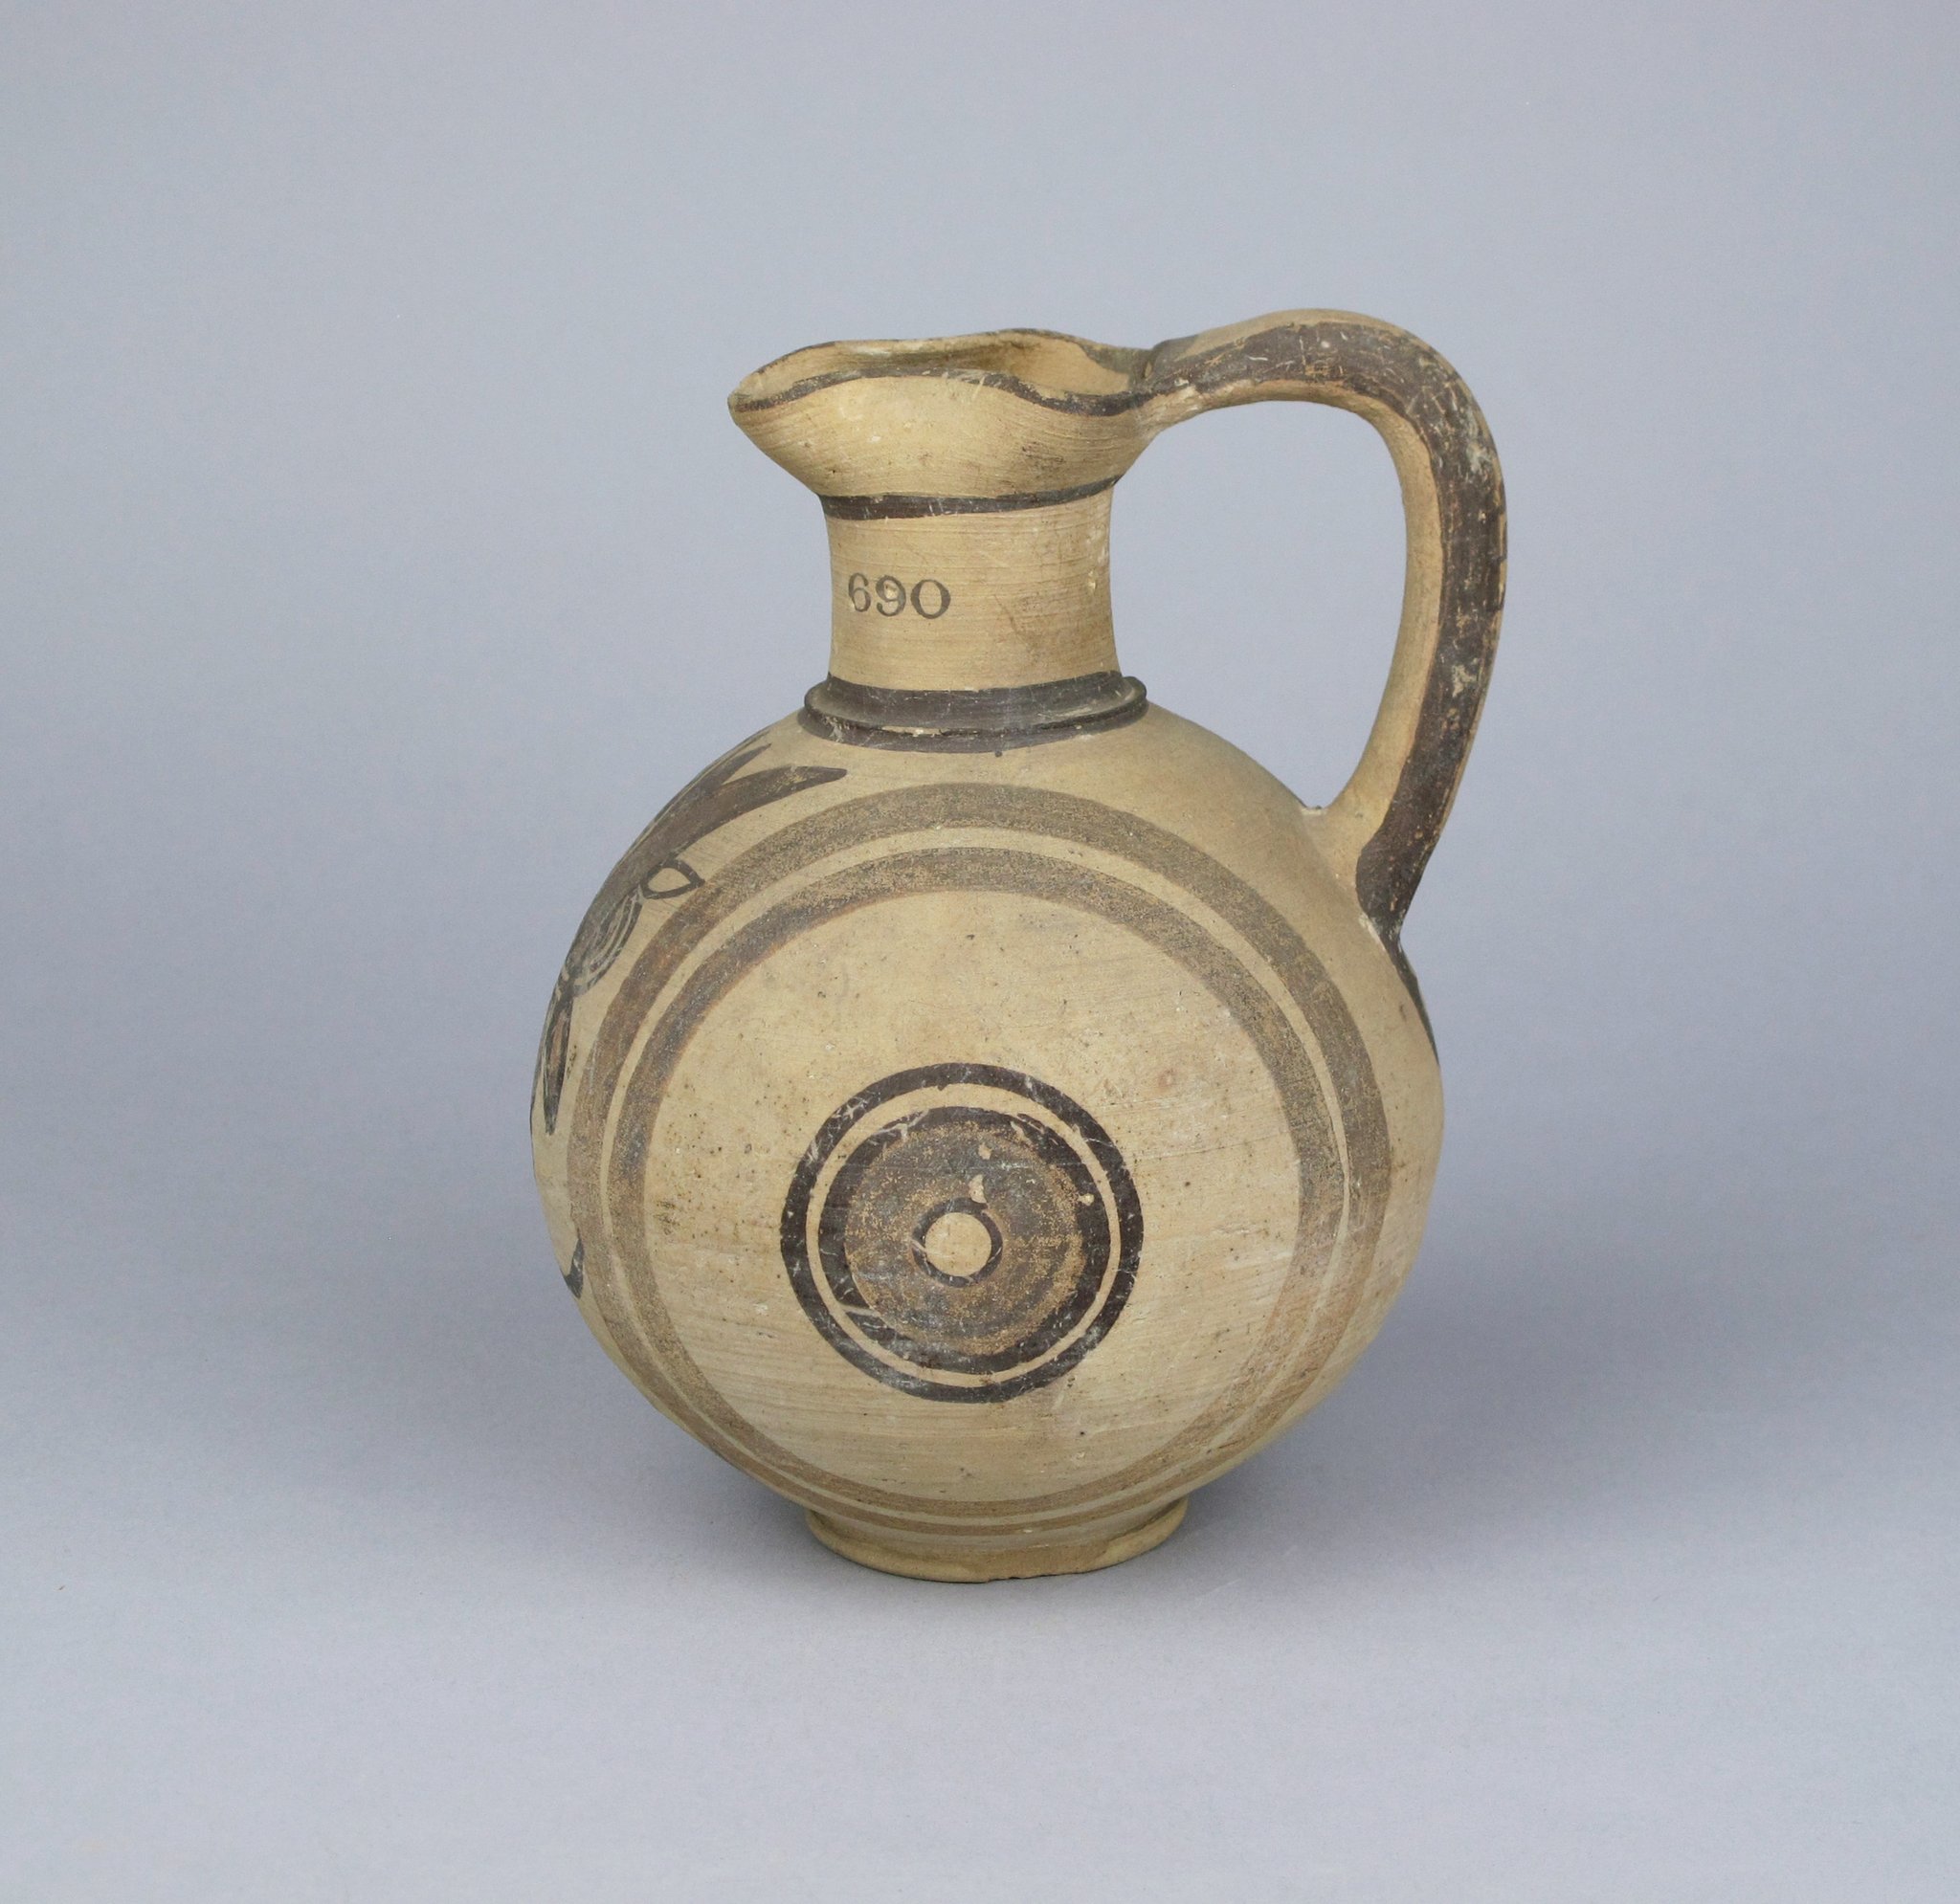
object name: juglet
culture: cypriot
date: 750-600 BCE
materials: terracotta